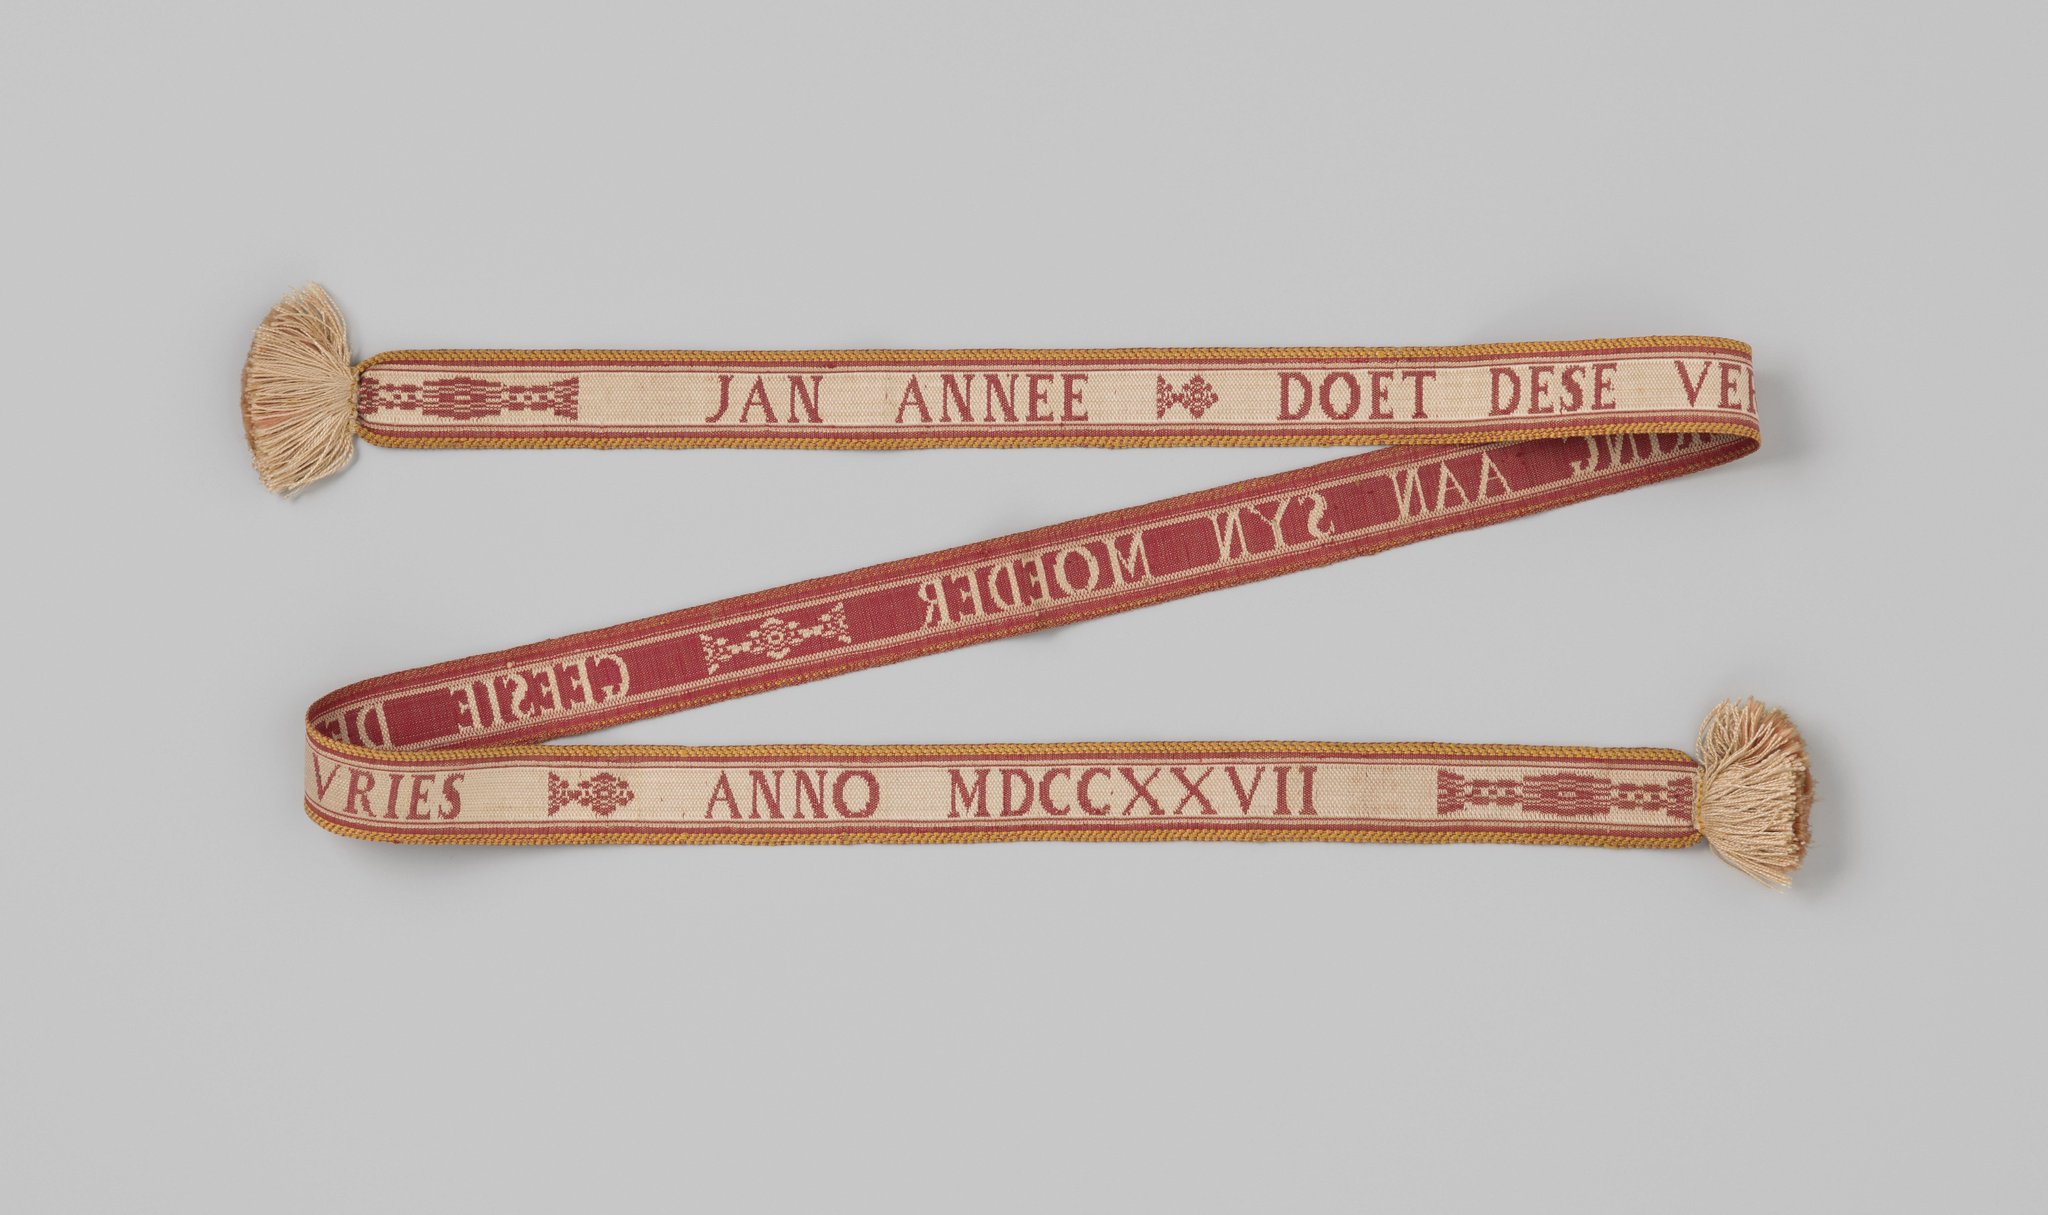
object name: garter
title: Kousenband van zijde, met de tekst, in rood op wit: JAN ANNEE DOET DESE VEREERING AAN SYN MOEDER GEESIE DE VRIES ANNO MDCCXXVII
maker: Anonymous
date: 1727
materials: silk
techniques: brocade, weave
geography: western europe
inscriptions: inscription: ‘JAN ANNEE DOET DESE VEREERING AAN SYN MOEDER GEESIE DE VRIES ANNO MDCCXXVII’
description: Kousenband van zijde, met de tekst, in rood op wit: JAN ANNEE DOET DESE VEREERING AAN SYN MOEDER GEESIE DE VRIES ANNO MDCCXXVII.